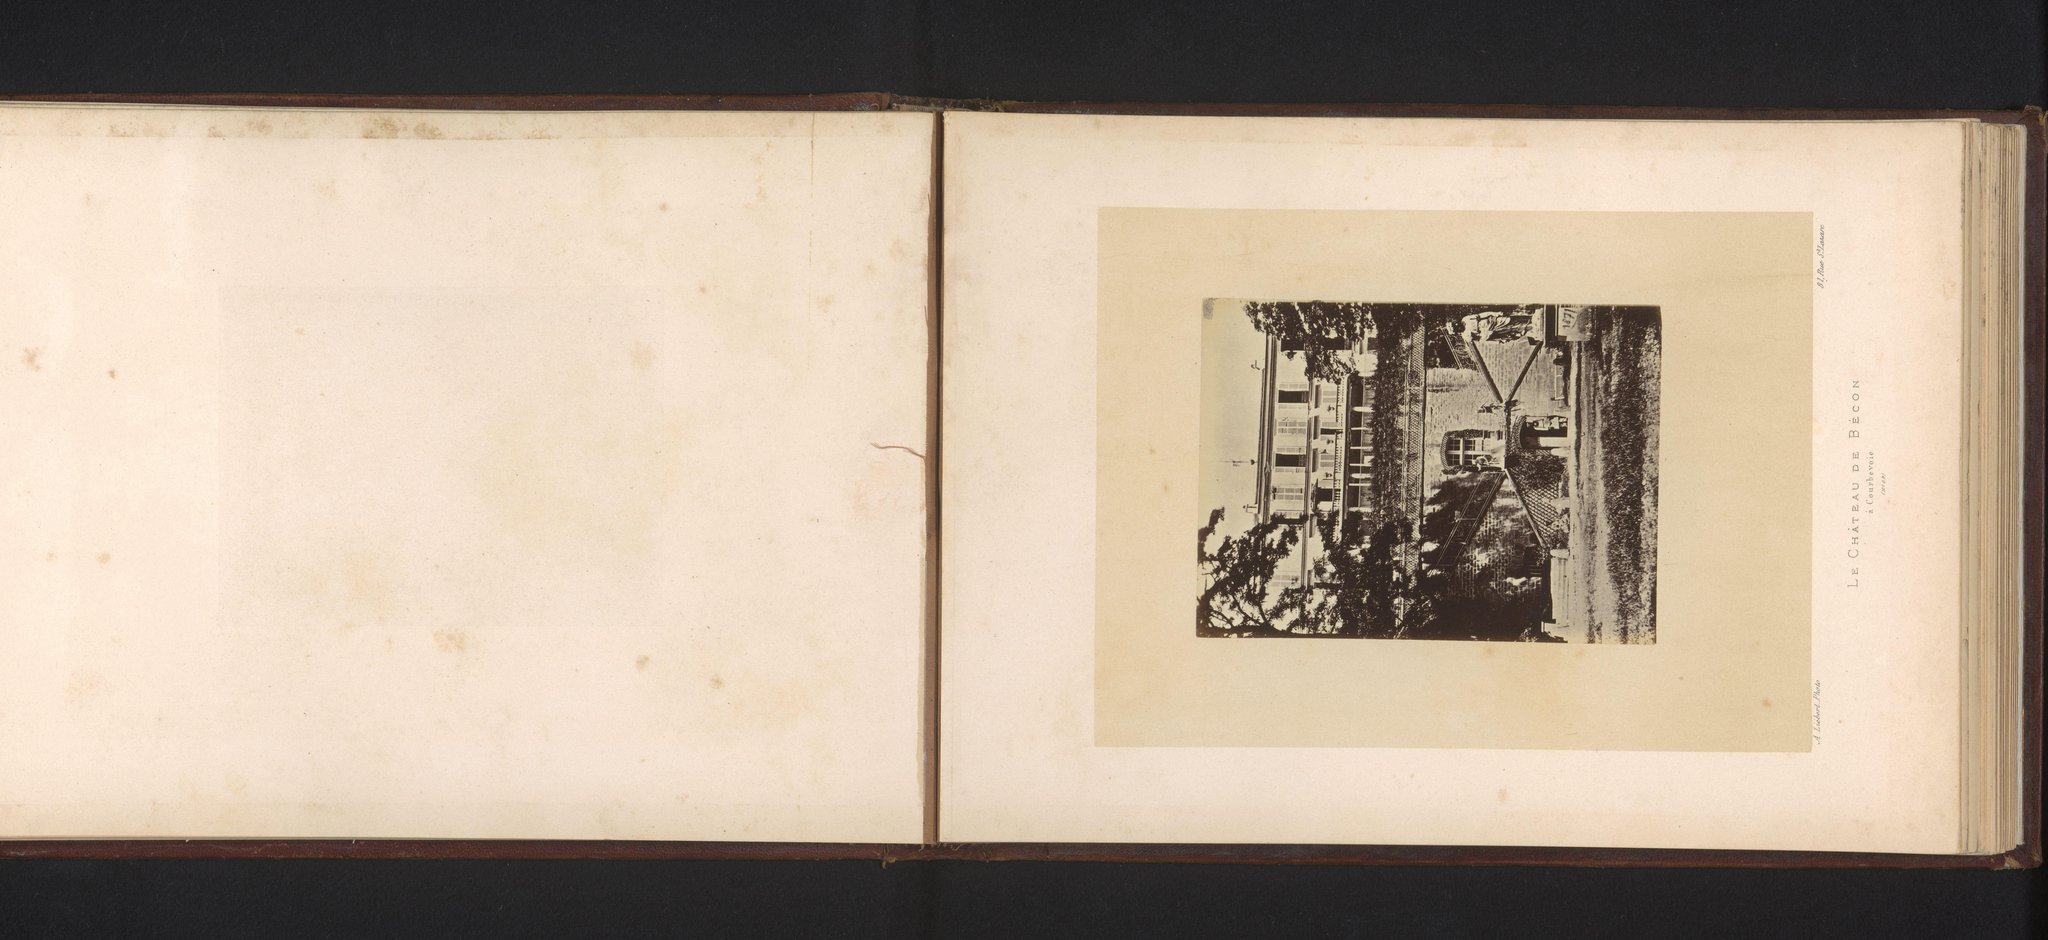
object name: page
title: Gezicht op het Château de Bécon in Courbevoie na de Commune van Parijs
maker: alphonse-justin liébert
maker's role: fotograaf, marinier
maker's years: 1827-1914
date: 1871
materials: photographic support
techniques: albumen print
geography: courbevoie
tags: castle, back steps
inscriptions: address: ‘31, Rue St. Lazare’, number: ‘(No. 64)’